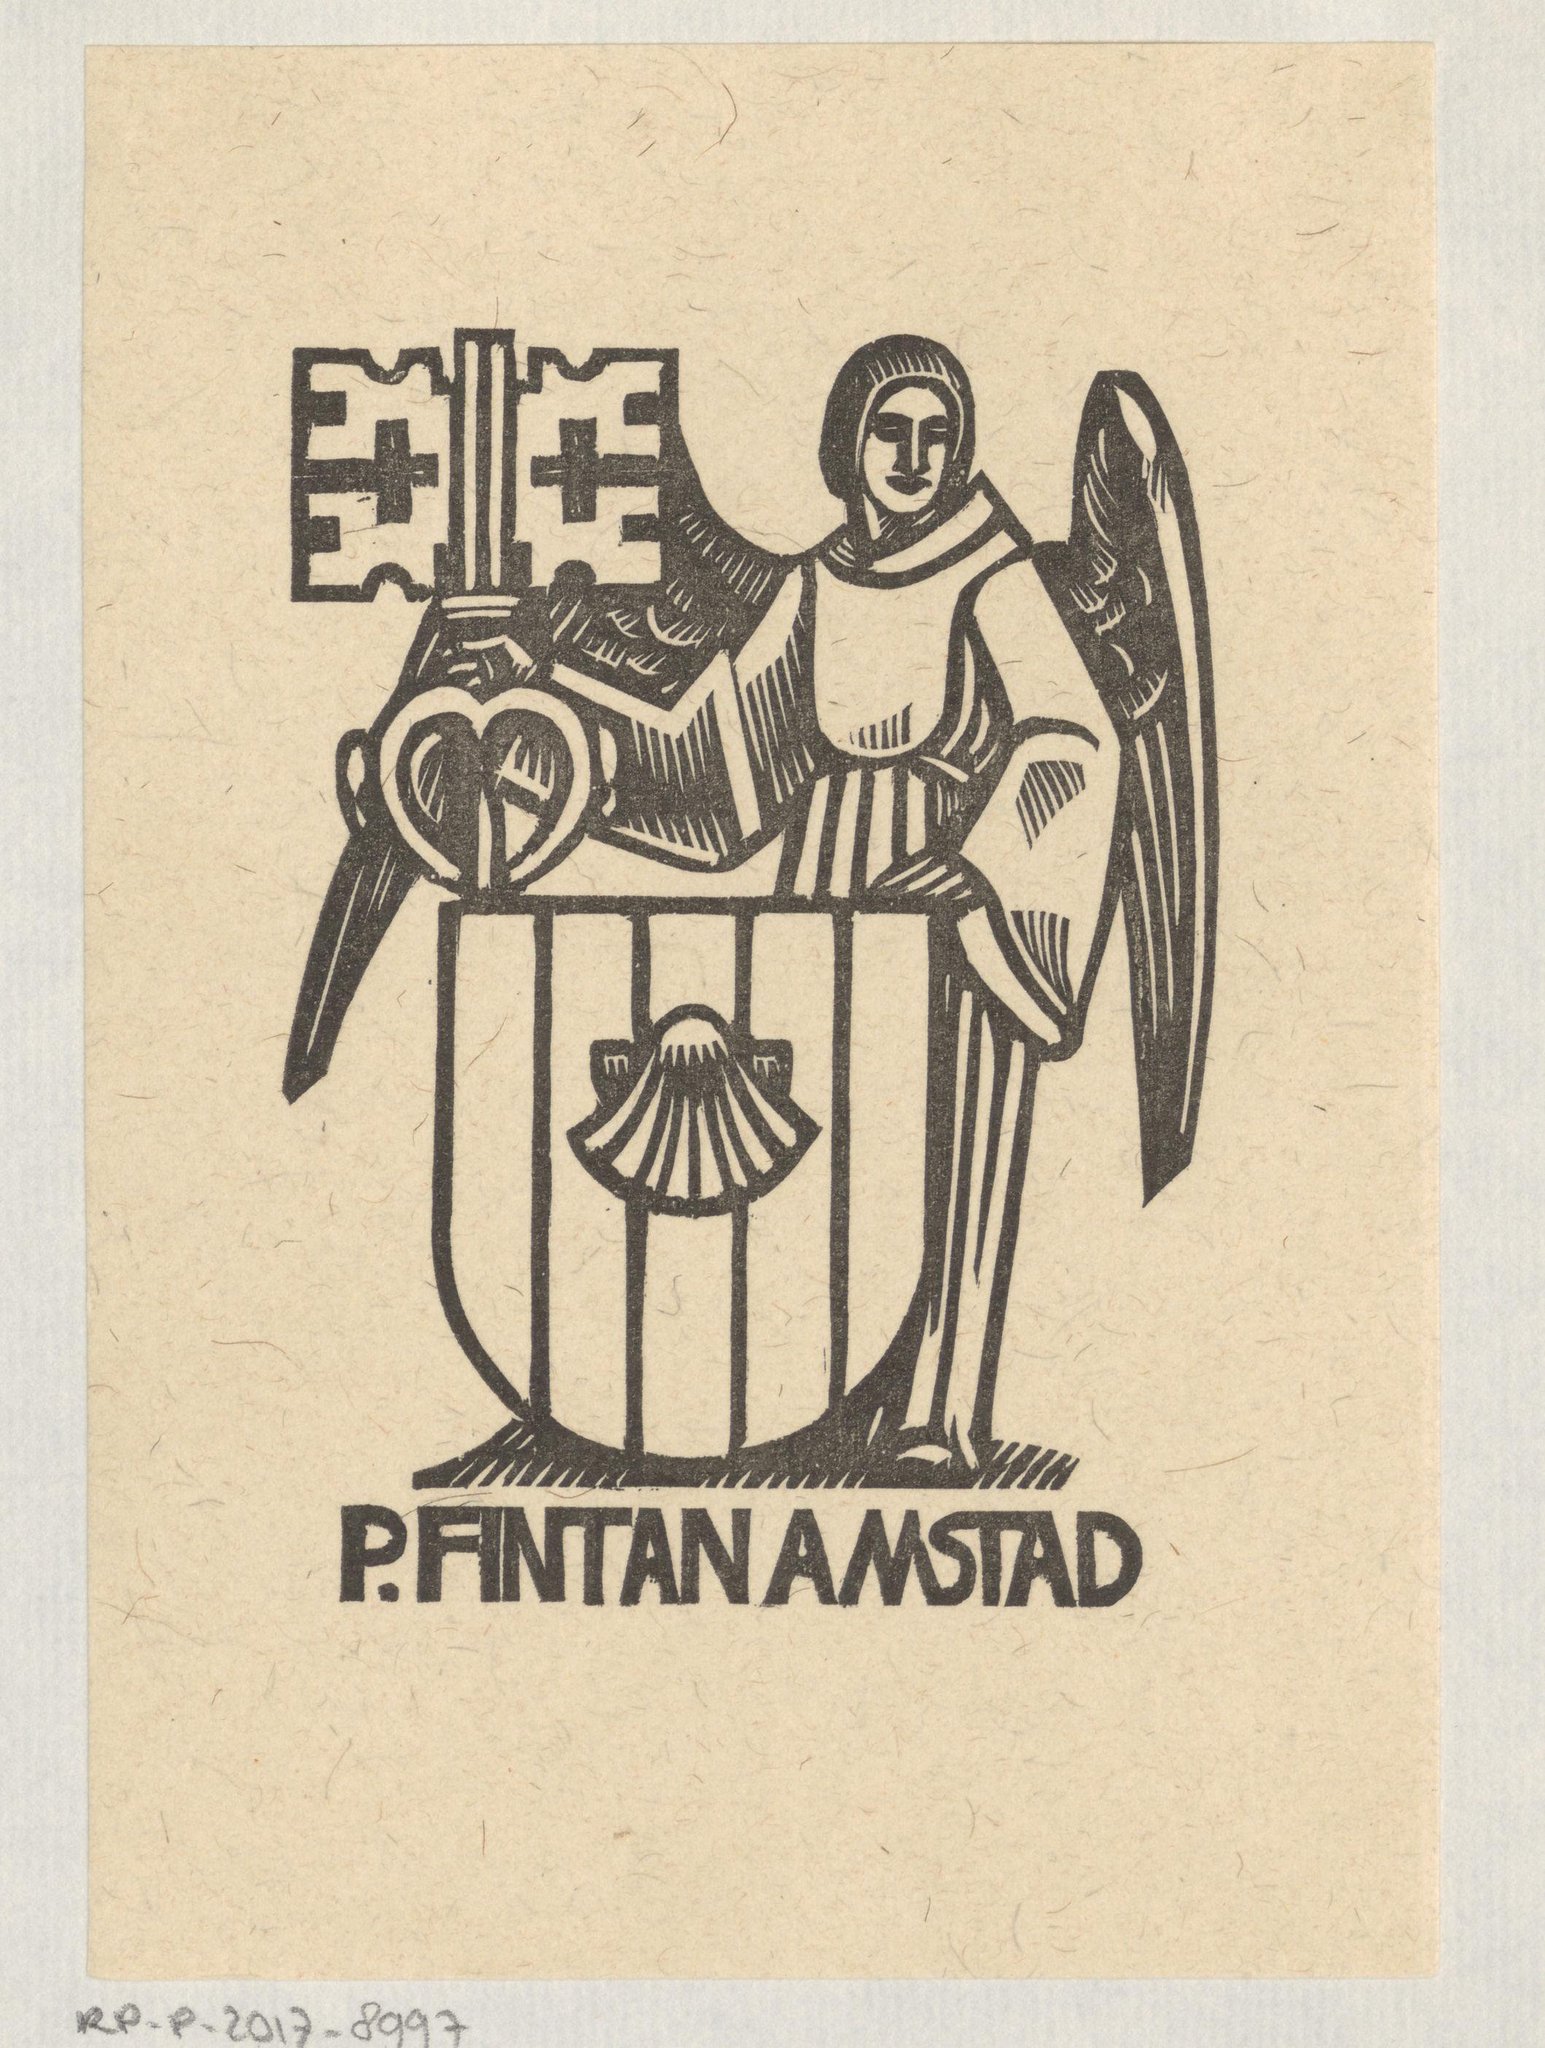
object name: bookplate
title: Ex libris van P. Fintan Amstad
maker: p. bernard füeller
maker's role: print maker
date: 1898-1973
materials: paper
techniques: woodcut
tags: key, angels, armorial bearing, heraldry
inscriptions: workshop stamp: ‘P. Bernard Füeller’